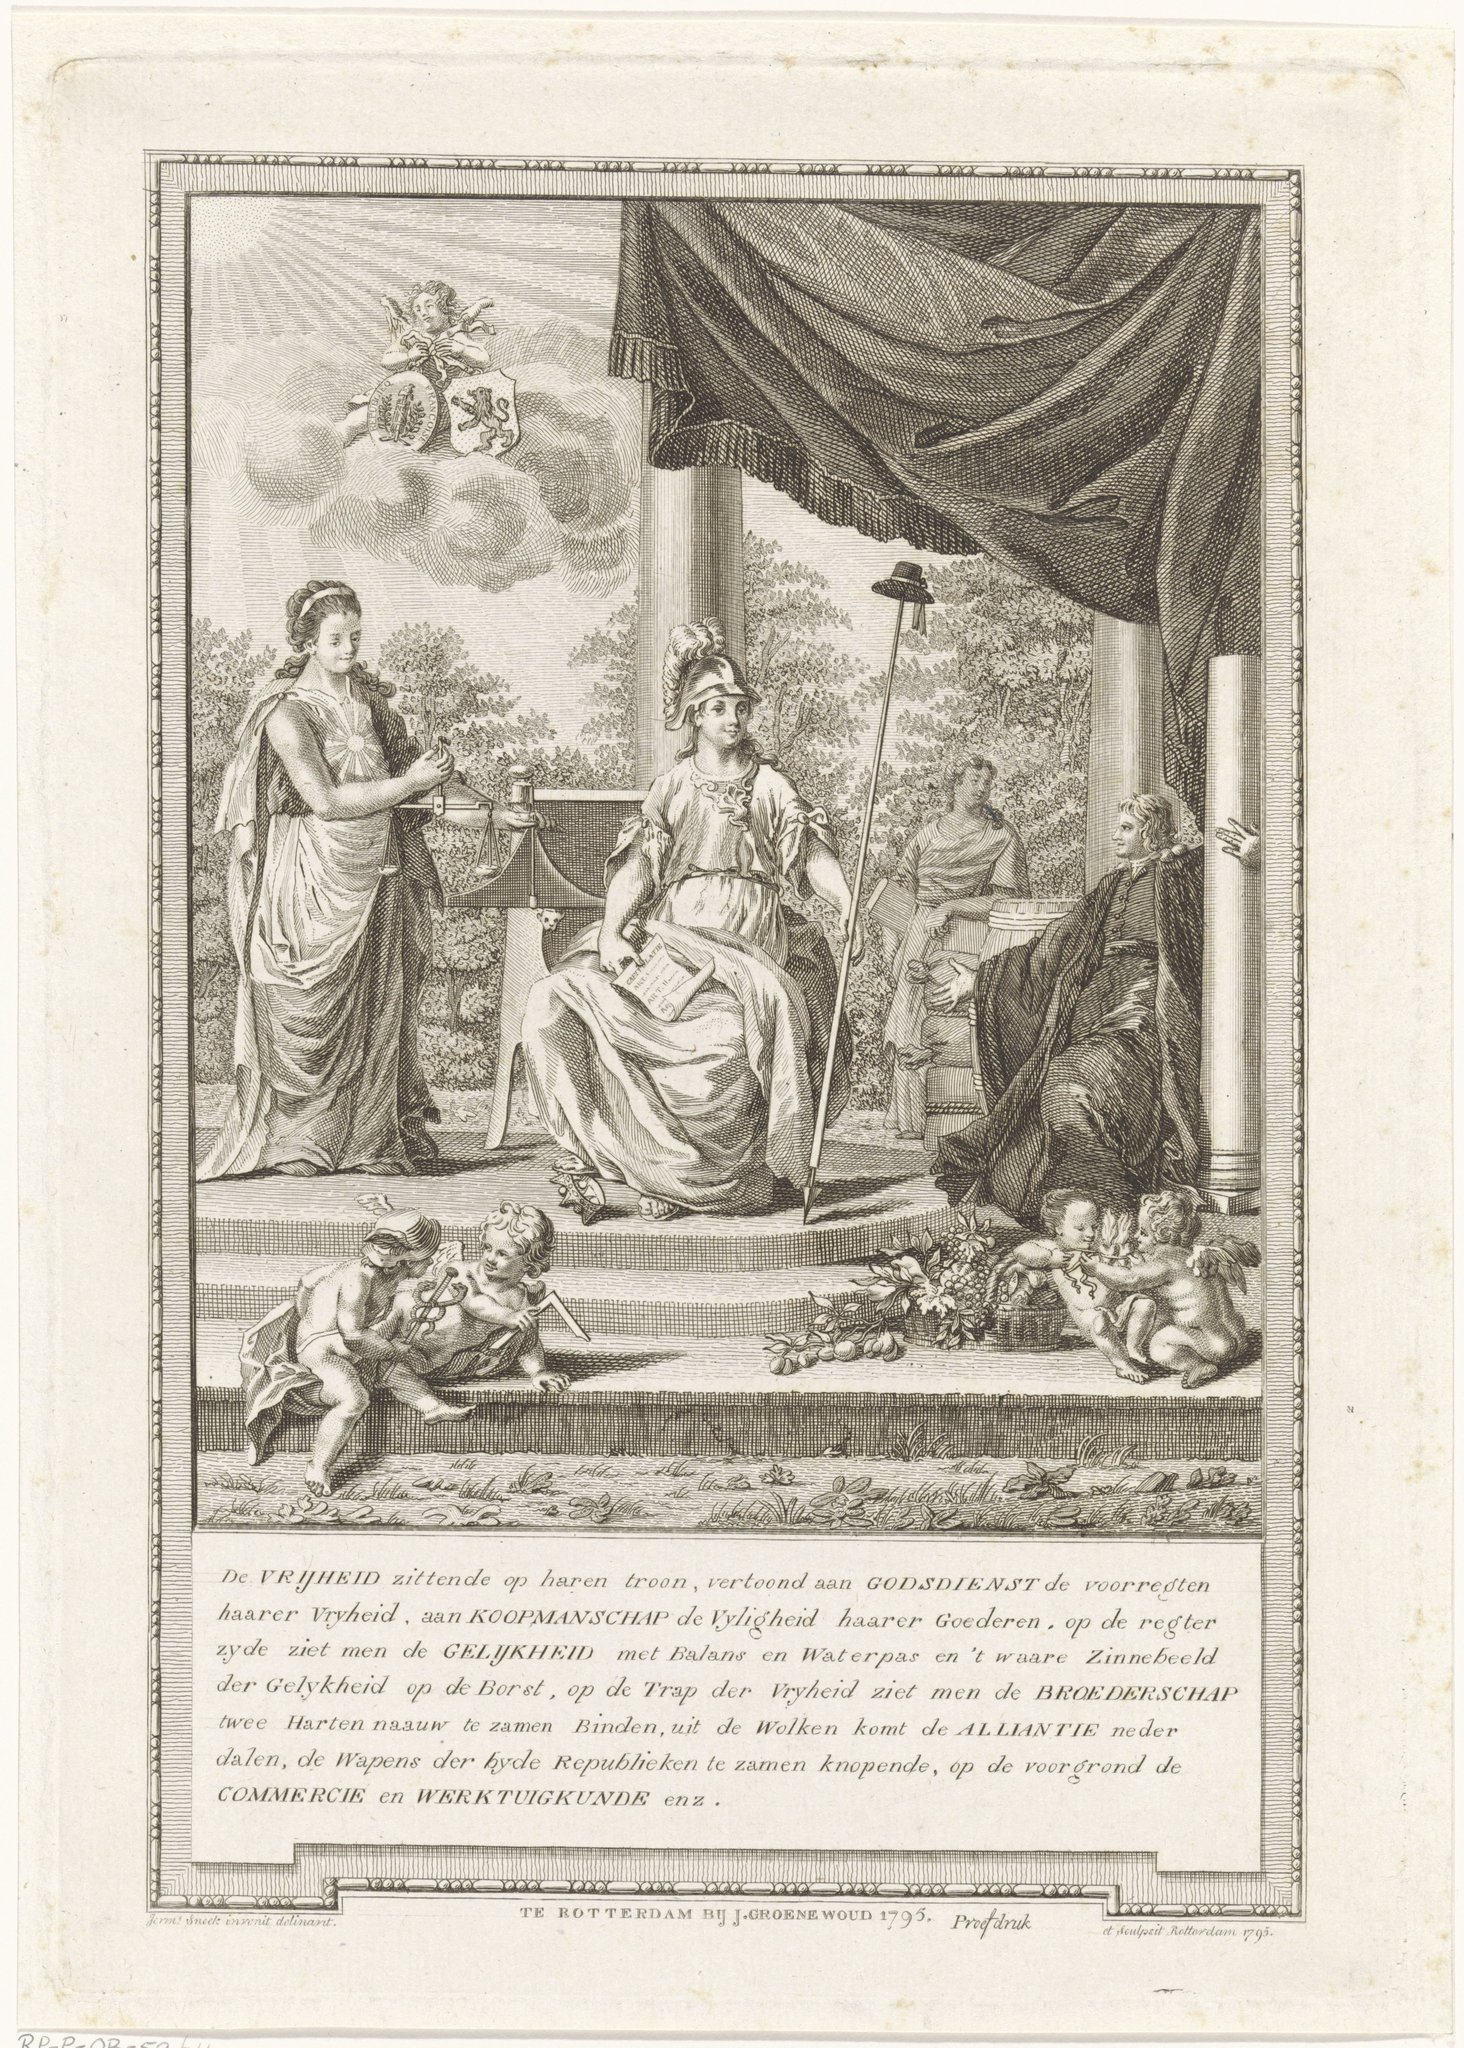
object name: print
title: Allegorie op de Alliantie met Frankrijk, 1795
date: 1795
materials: paper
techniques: engraving, etching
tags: equality, equity, fairness, righteousness; 'equalità', 'equità', 'giuditio giusto', 'ordine dritto e giusto', 'ugualità' (ripa) (+ abstract concept represented by female figure), allegorical representations ~ religion; 'religione', 'religione de ss. mauritio e lazaro', 'religione vera christiana' (ripa), freedom, liberty; 'libertà' (ripa) (+ abstract concept represented by female figure), alliance with france (1795)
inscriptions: collector's mark: Lugt 2228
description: Allegorie op de Alliantie gesloten tussen de Bataafse Republiek en Frankrijk, 1795. Centraal de Vrijheid zittend op een troon, achter haar de Koopmanschap, links de Gelijkheid en rechts de Godsdienst (een predikant). Op de trappen links twee kinderen als de Commercie en Werktuigkunde, rechts twee kinderen als de Broederschap. In de wolken de Alliantie met de Franse en Nederlandse wapens. Vóór het onderschrift met de uitleg van de voorstelling.